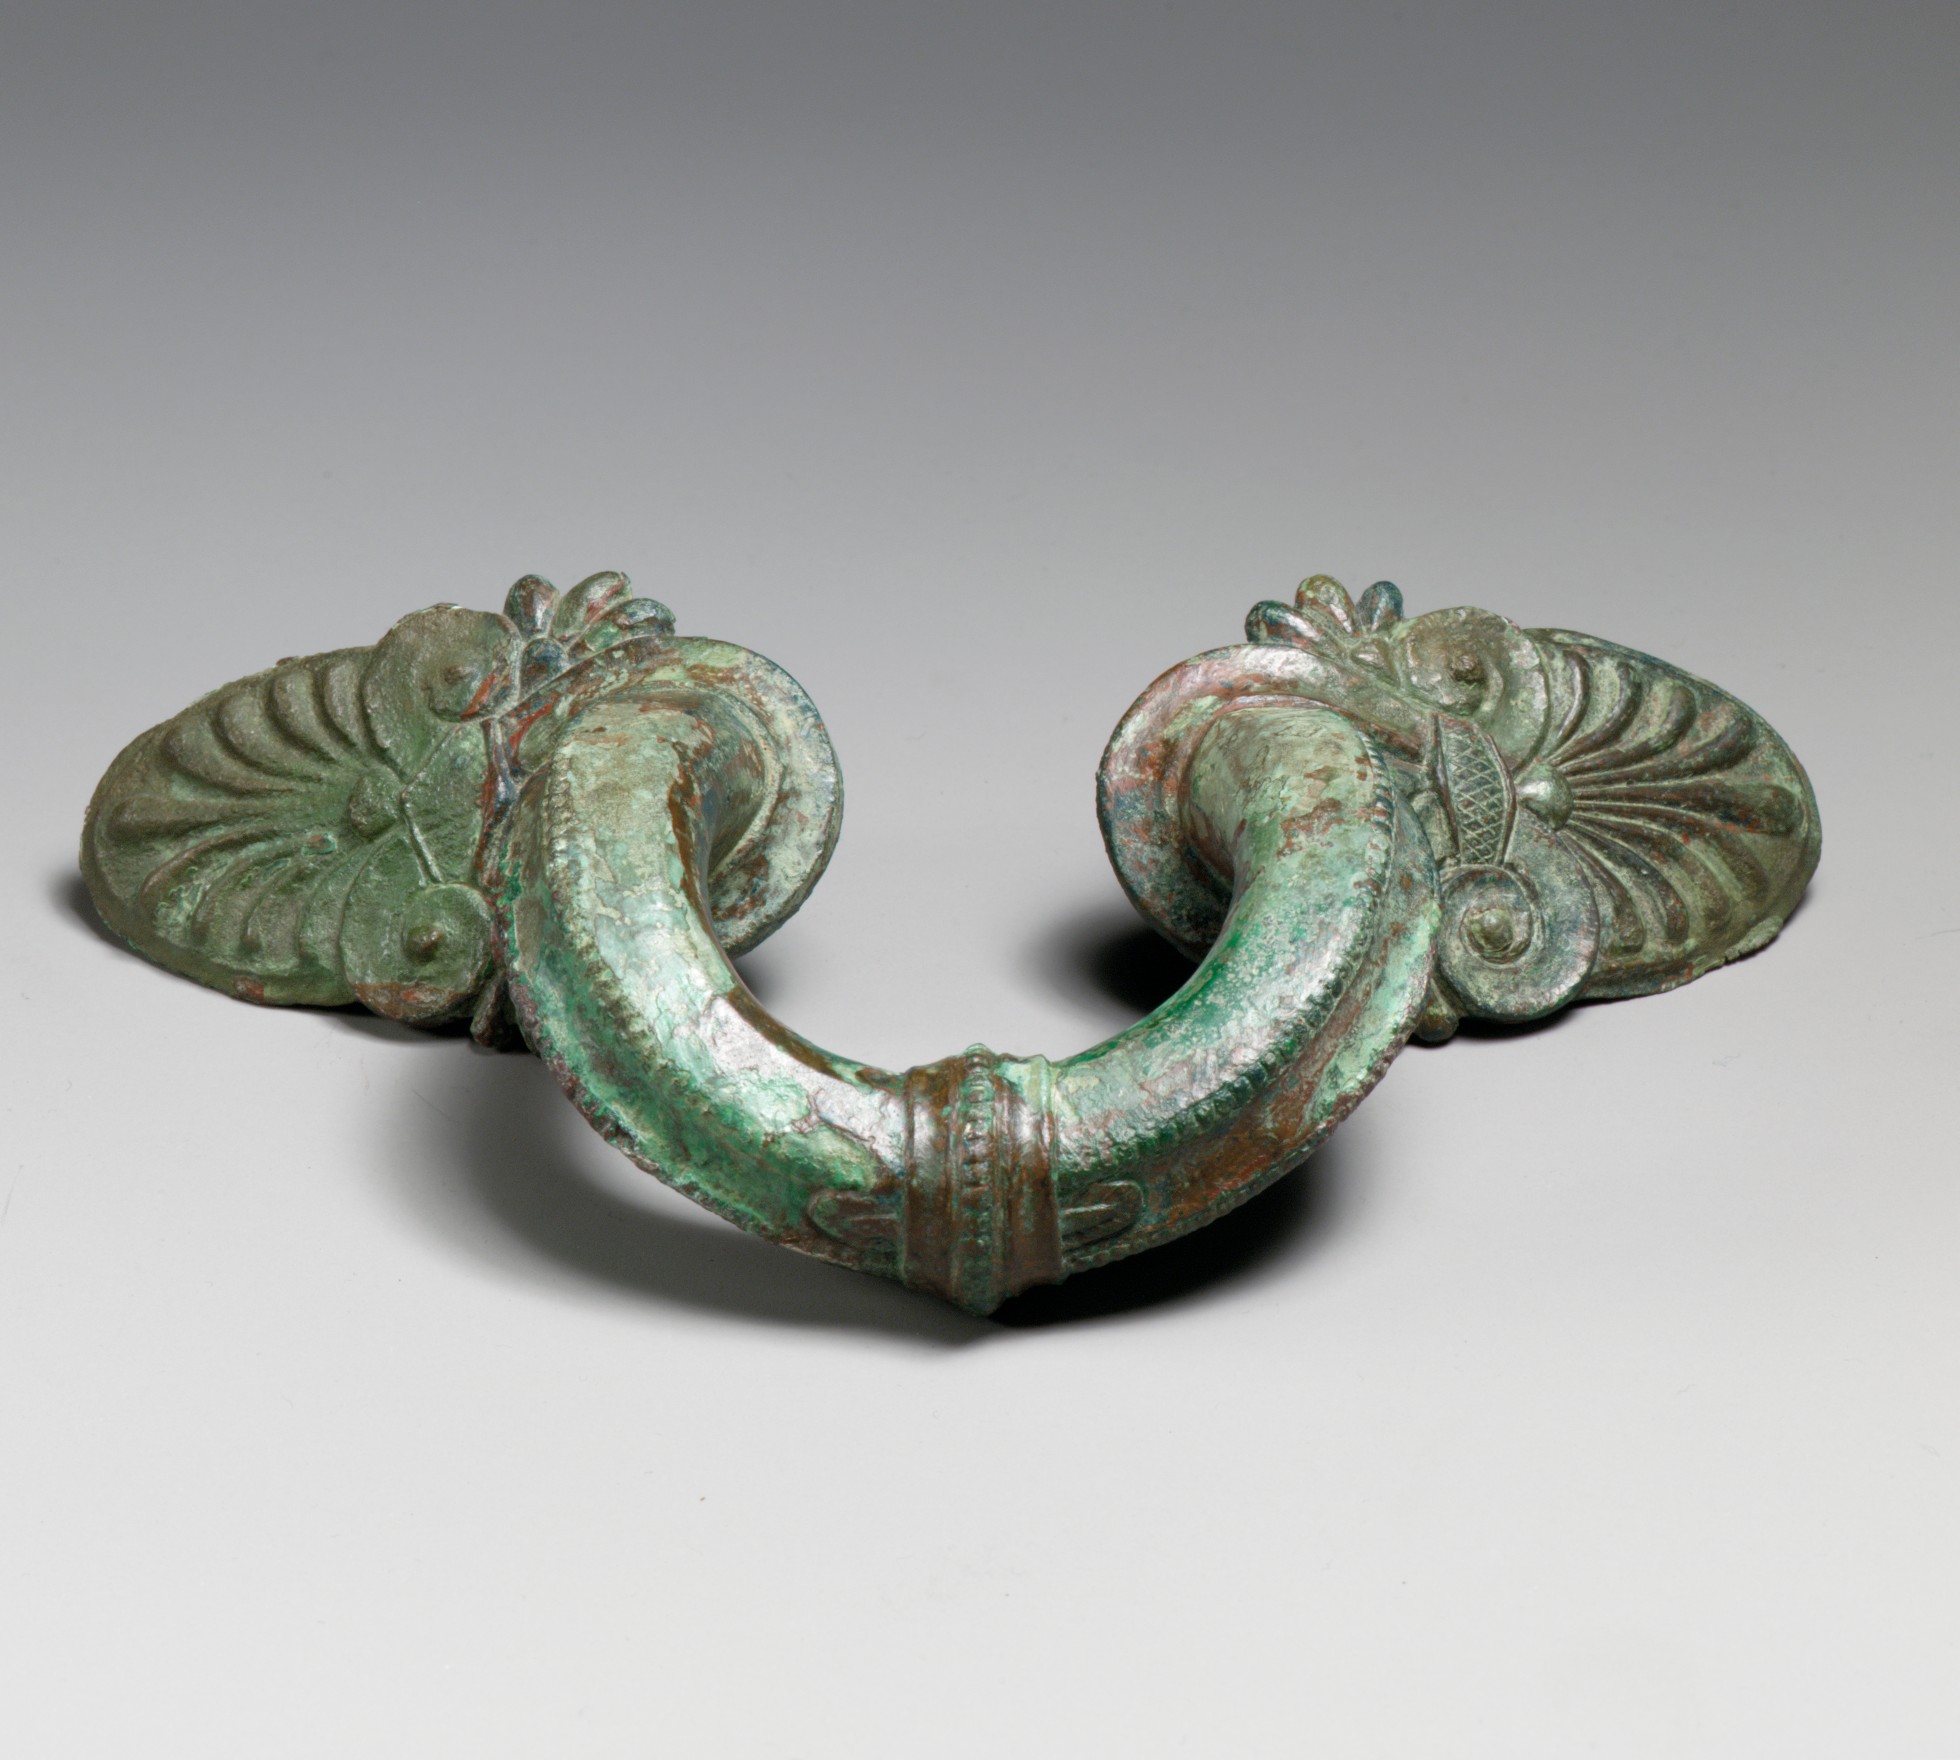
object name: handle of a hydria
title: Bronze handle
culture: greek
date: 500-401 BCE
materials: bronze